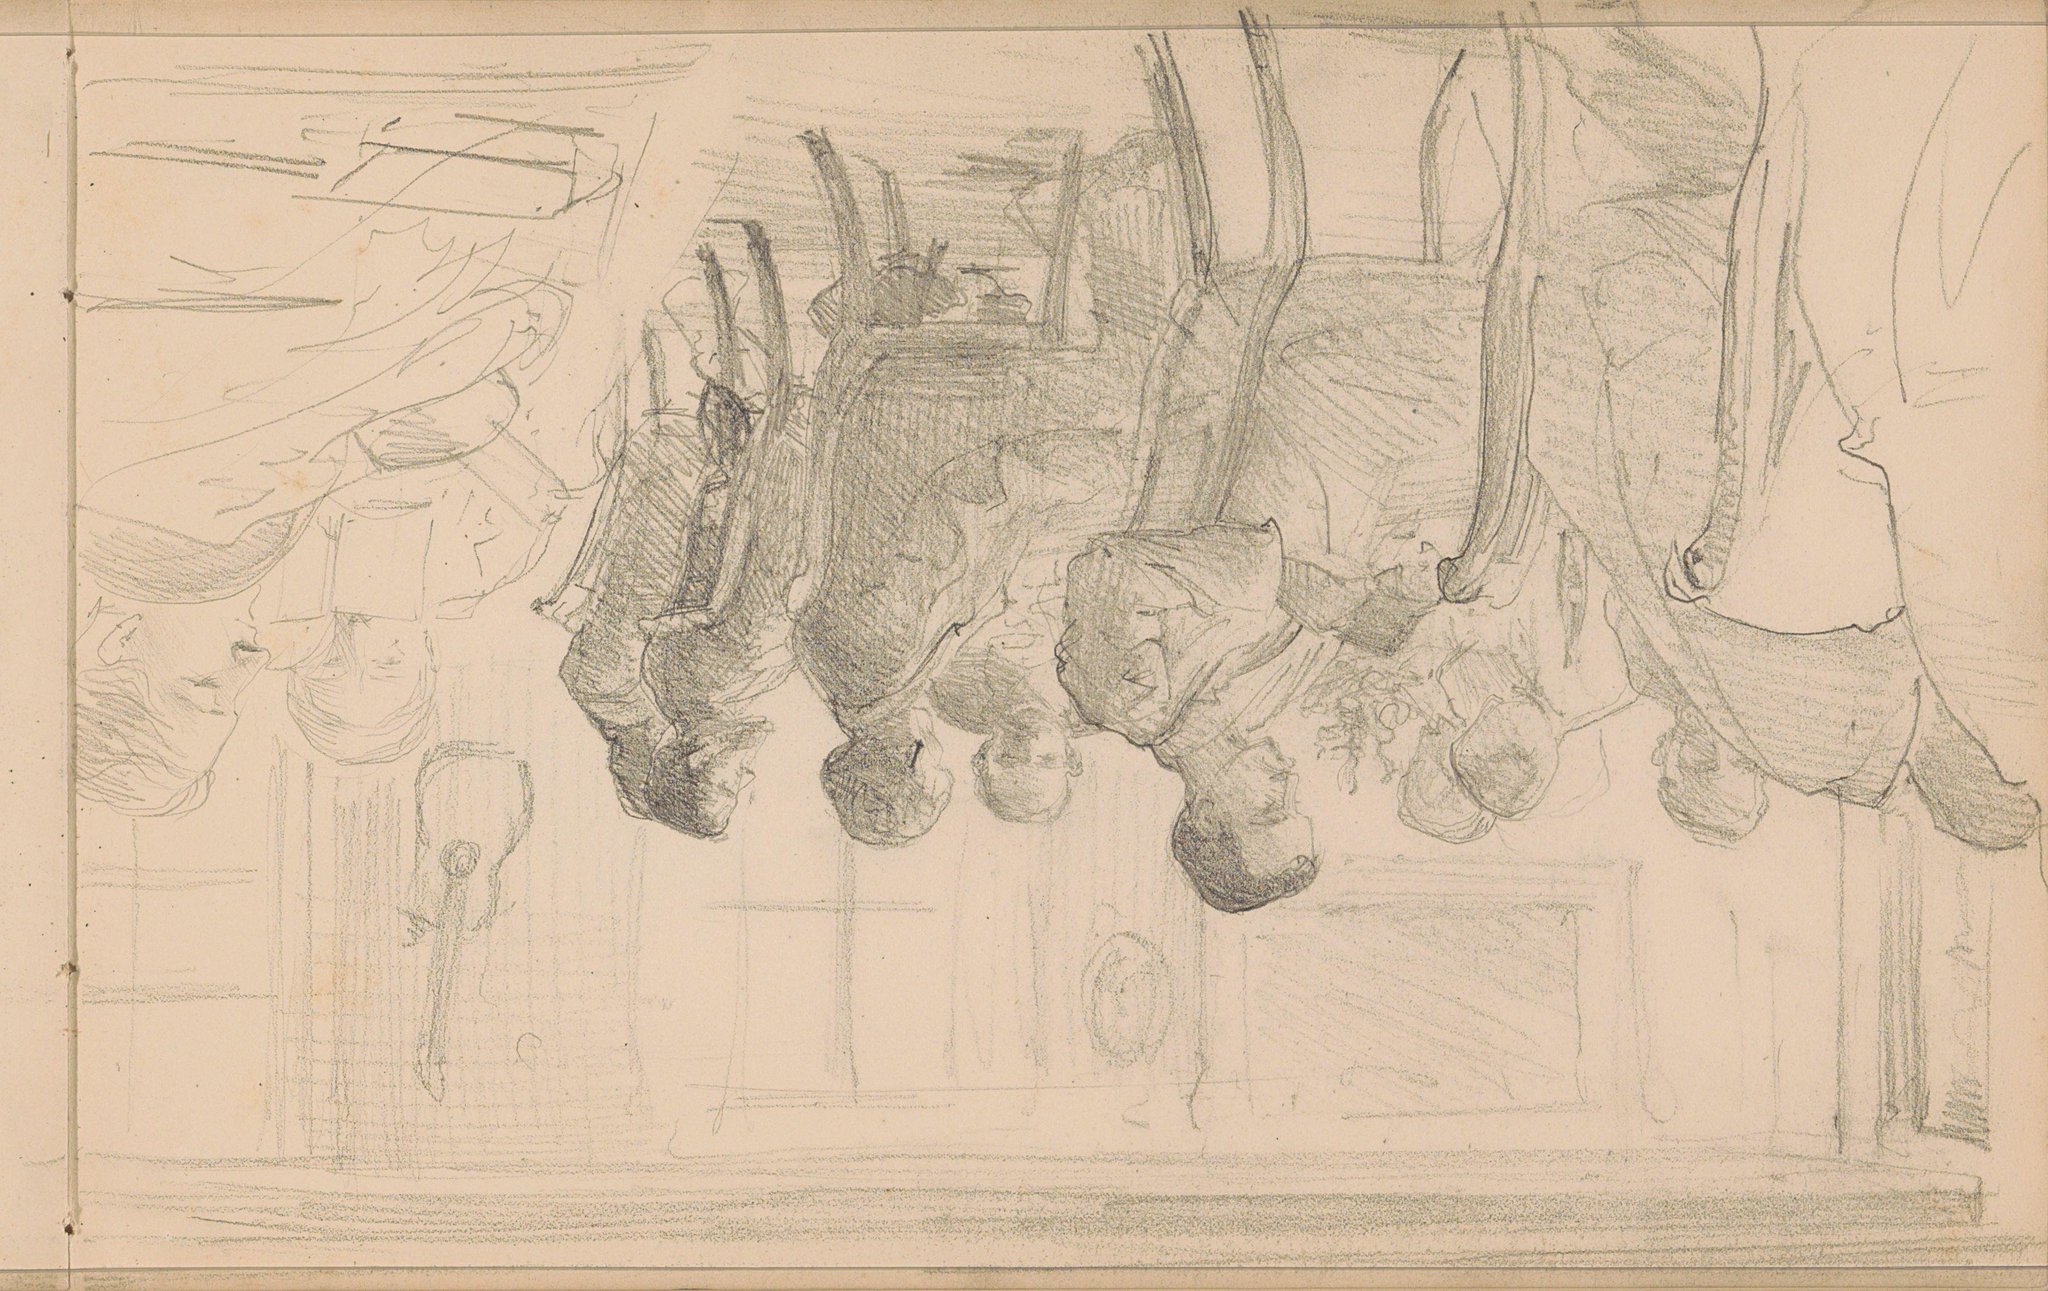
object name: sketchbook leaf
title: Eetzaal met figuren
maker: a.a.l. de grammont-hubrecht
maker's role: draughtsman, painter, print maker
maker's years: 1855-1913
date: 1865-1913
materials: paper, pencil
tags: sitting figure, dining-room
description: De eetzaal, mogelijk van een pension of hotel, is gedecoreerd met onder andere een schilderij en gitaar aan de muur. Blad 11 recto uit een schetsboek met 65 bladen.